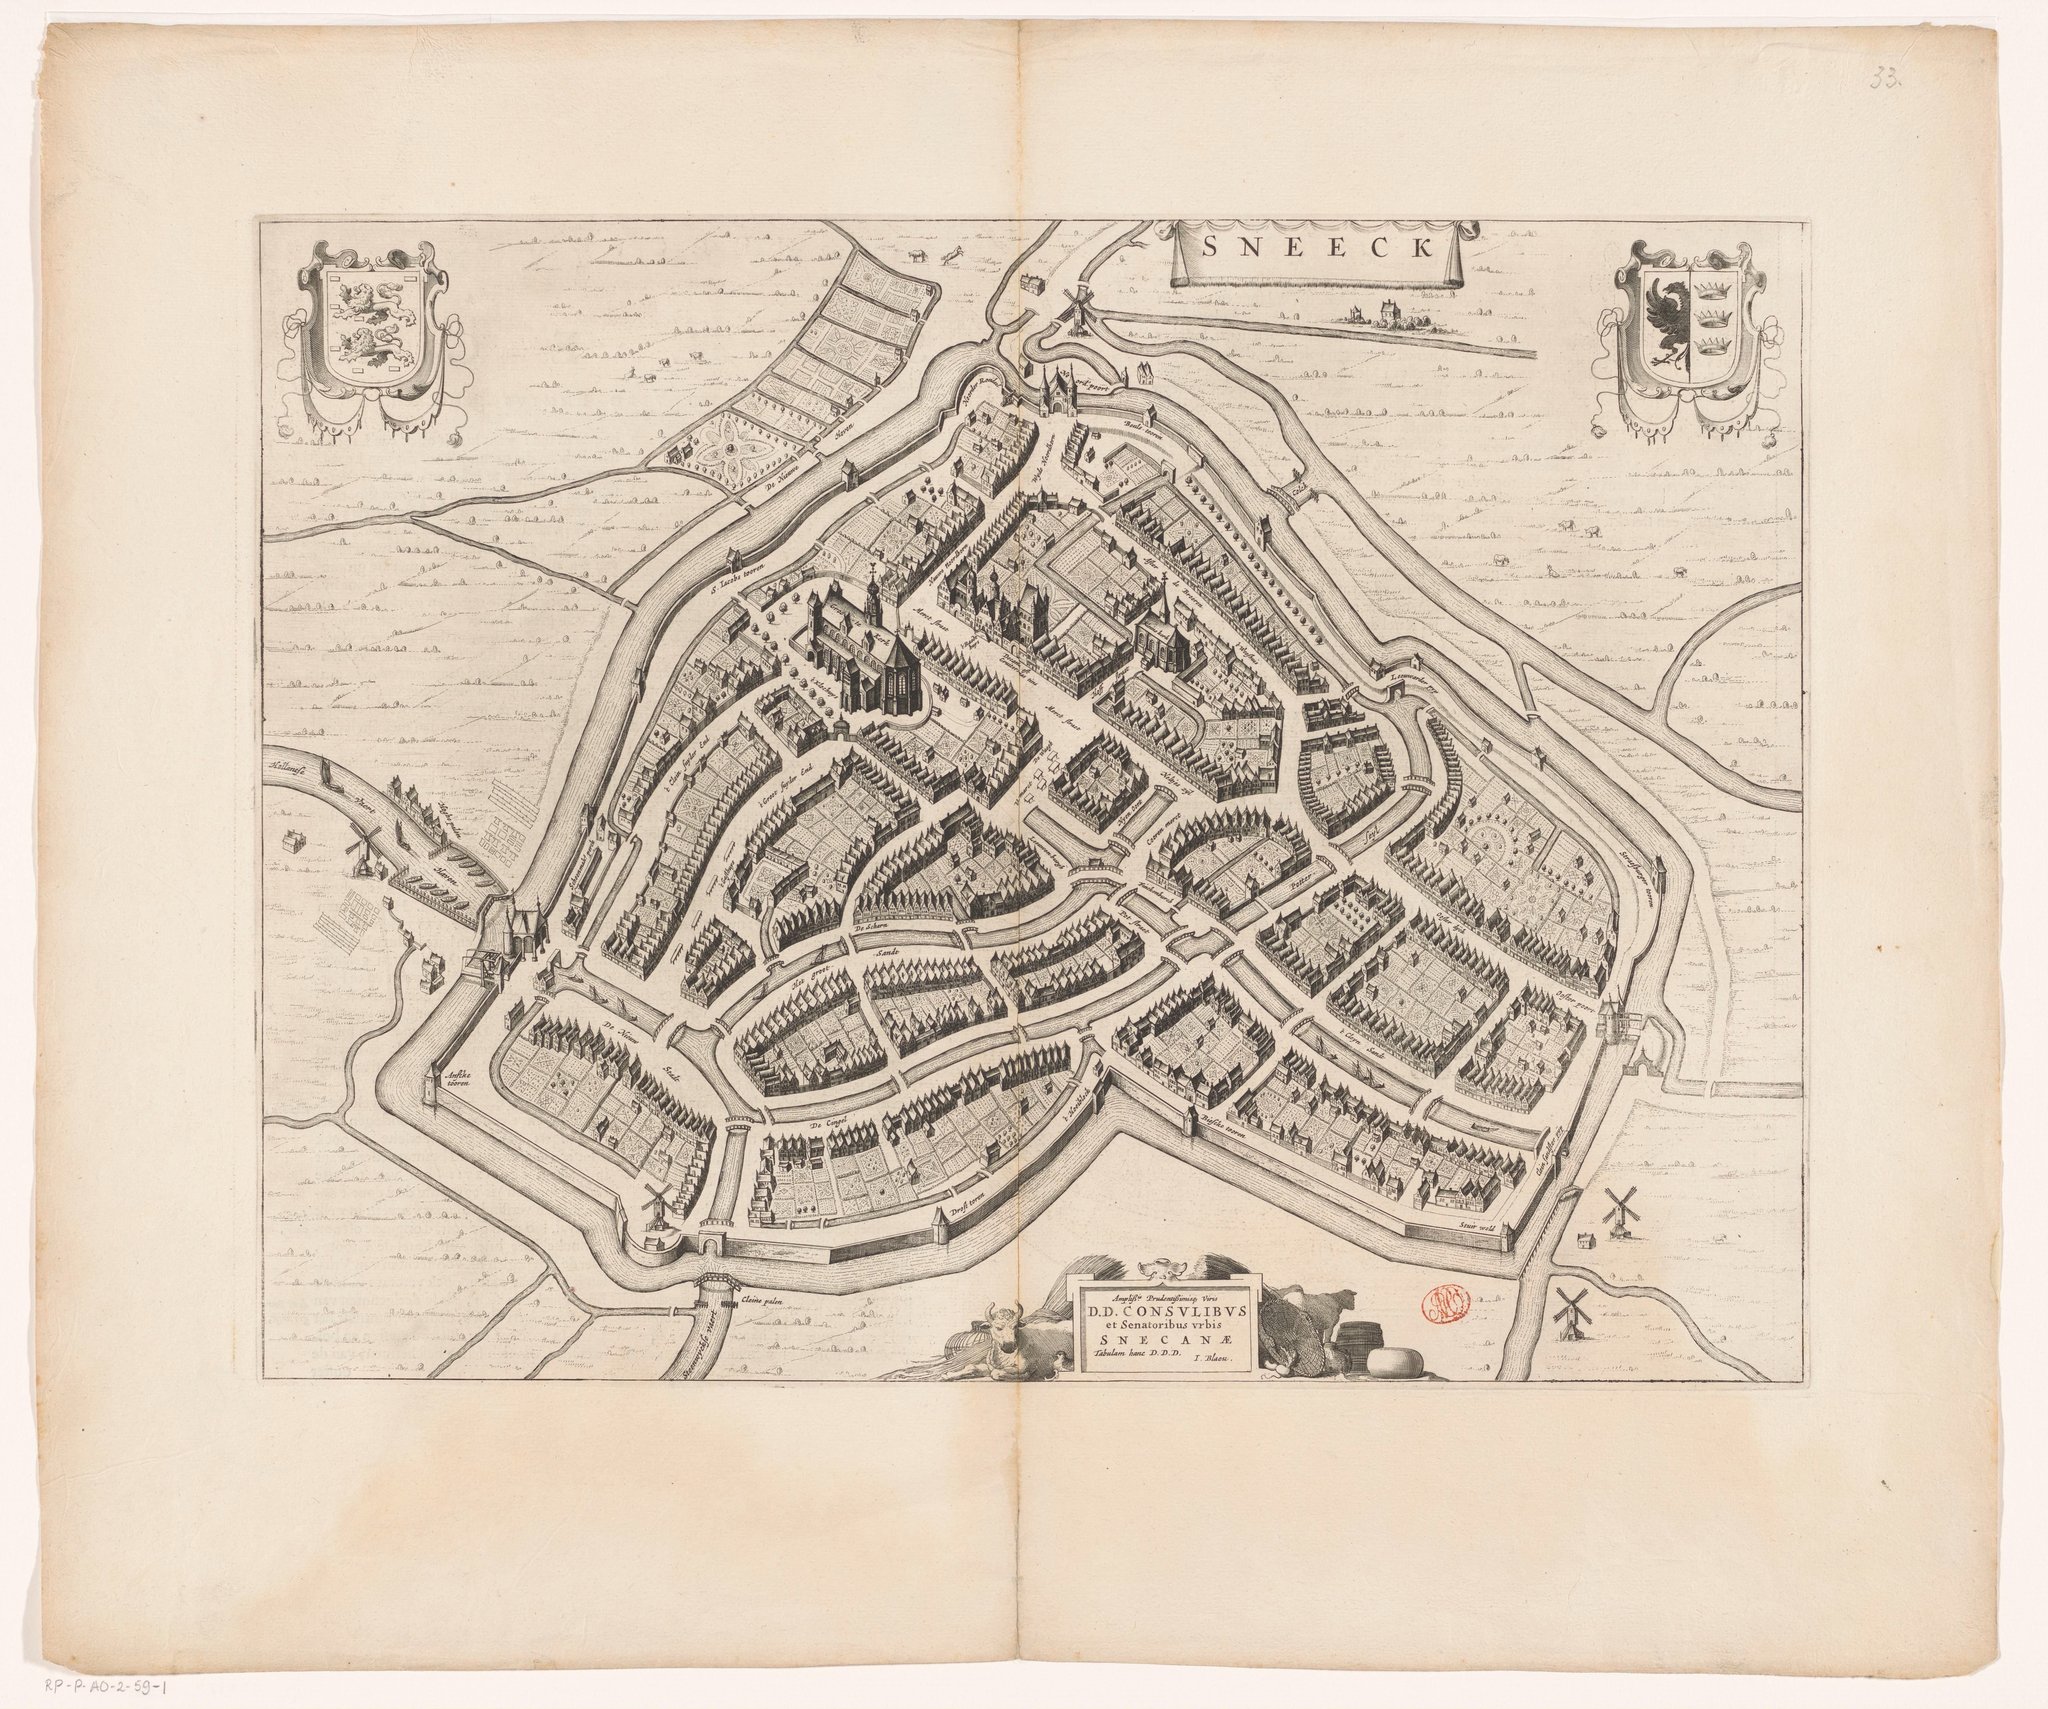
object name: area plan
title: Plattegrond van Sneek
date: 1652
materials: paper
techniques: engraving, etching, letterpress printing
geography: sneek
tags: coat of arms (as symbol of the state, etc.), agriculture, maps of cities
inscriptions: collector's mark: Lugt 2228, collector's mark: Lugt 195, label: ‘264’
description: Plattegrond in vogelvluchtperspectief. Linksboven het wapen van Friesland, rechtsboven titel en het wapen van Sneek. Onderaan de kaart cartouche met opdracht. Op verso Nederlandse tekst.